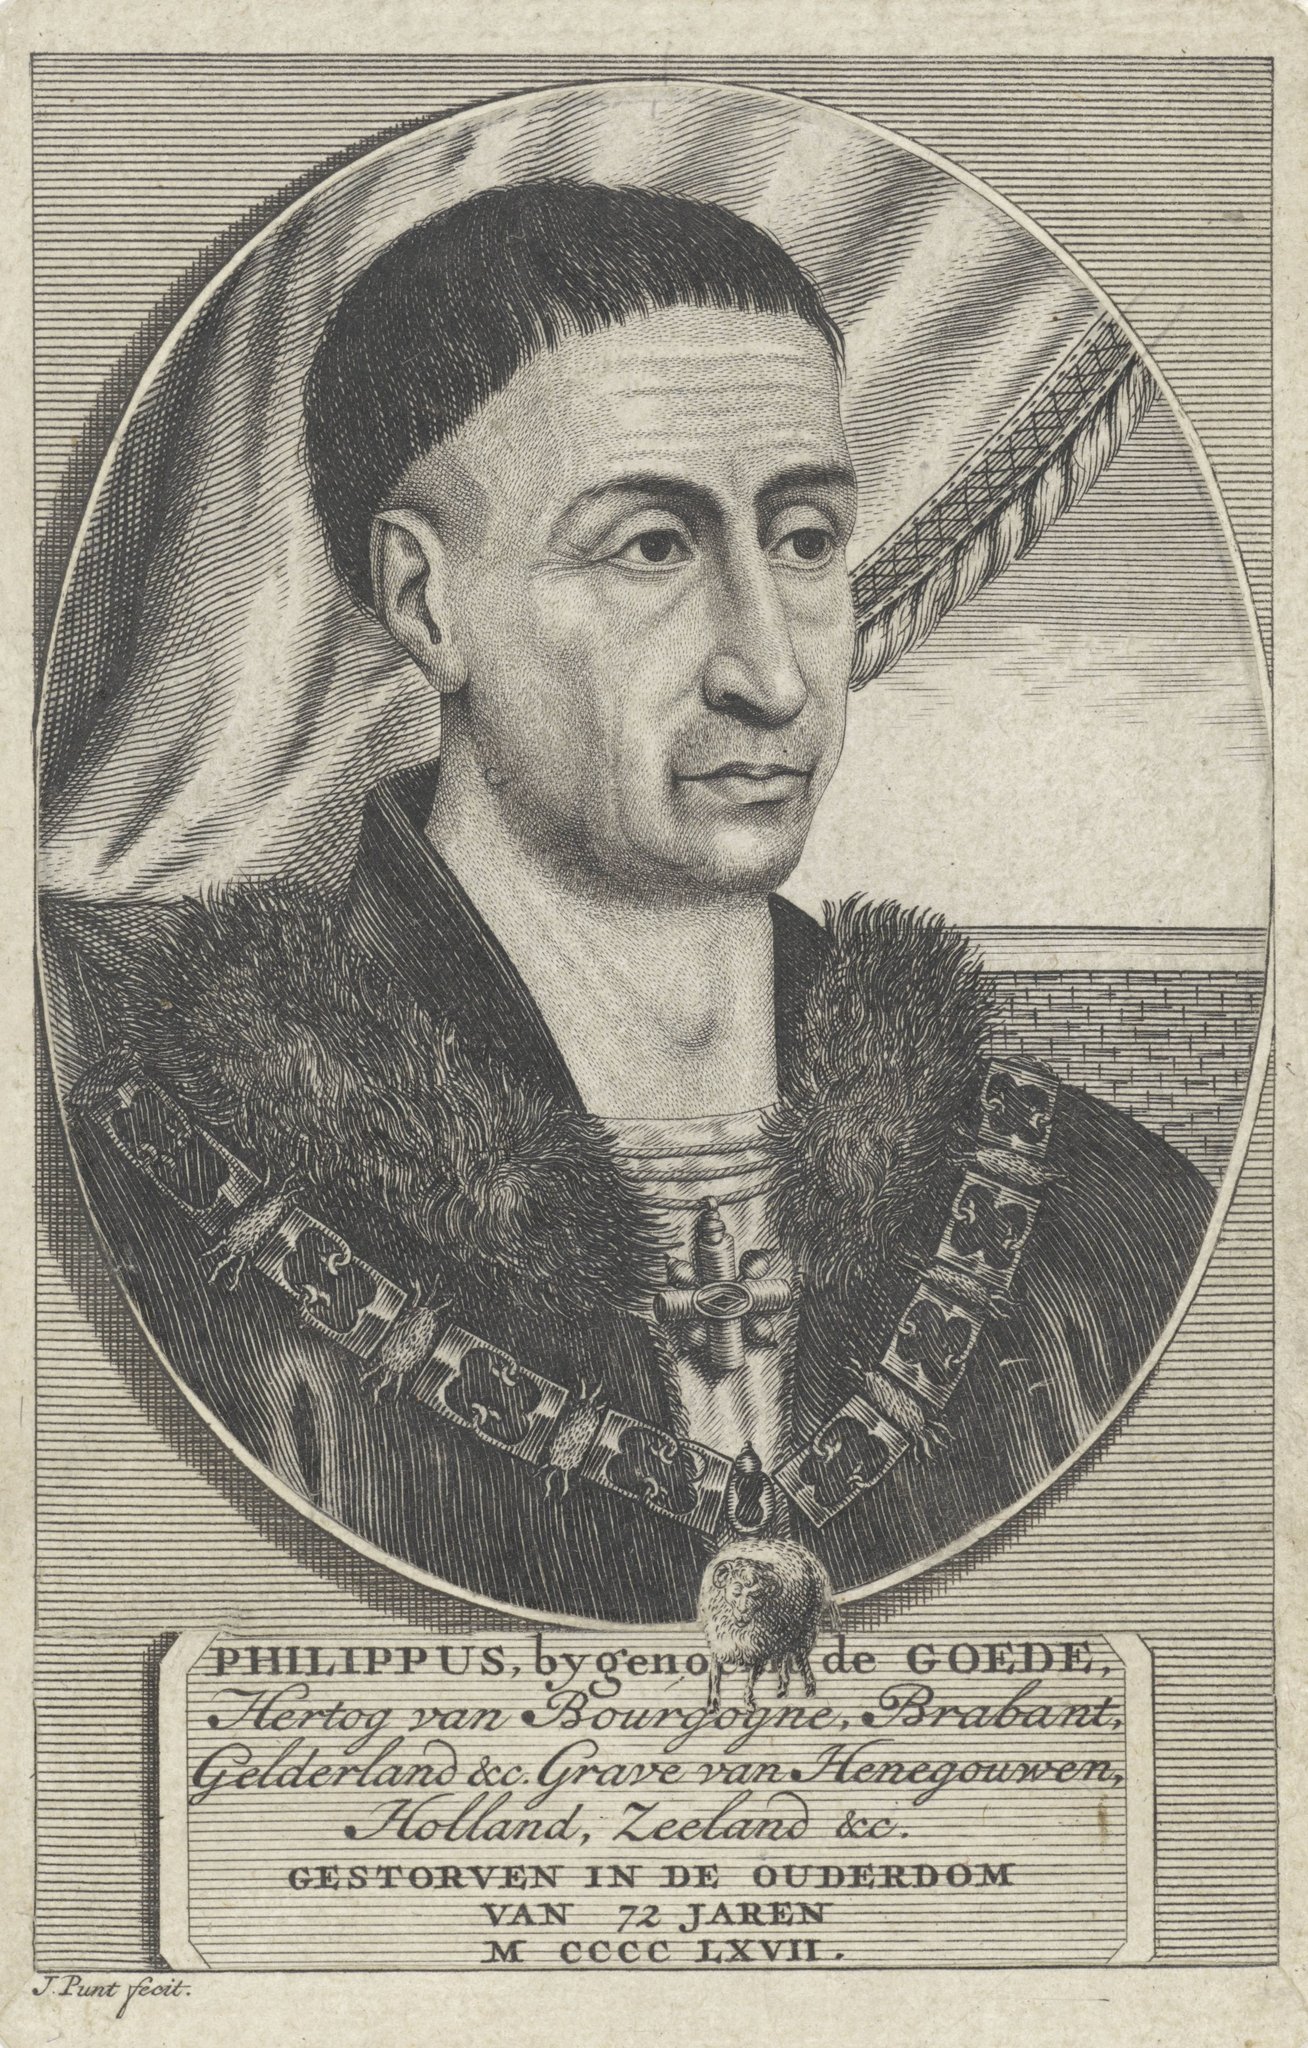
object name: print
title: Portret van Filips de Goede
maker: jan punt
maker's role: draughtsman, print maker, publisher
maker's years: 1711-1779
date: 1726-1779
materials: paper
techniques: engraving, etching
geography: northern netherlands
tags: philip iii the good, knighthood order of the golden fleece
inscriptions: collector's mark: Lugt 2228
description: Portret van Filips de Goede. Hij draagt een keten met de Orde van het Gulden Vlies. In het kader zijn naam, functies en sterfdatum in het Nederlands.